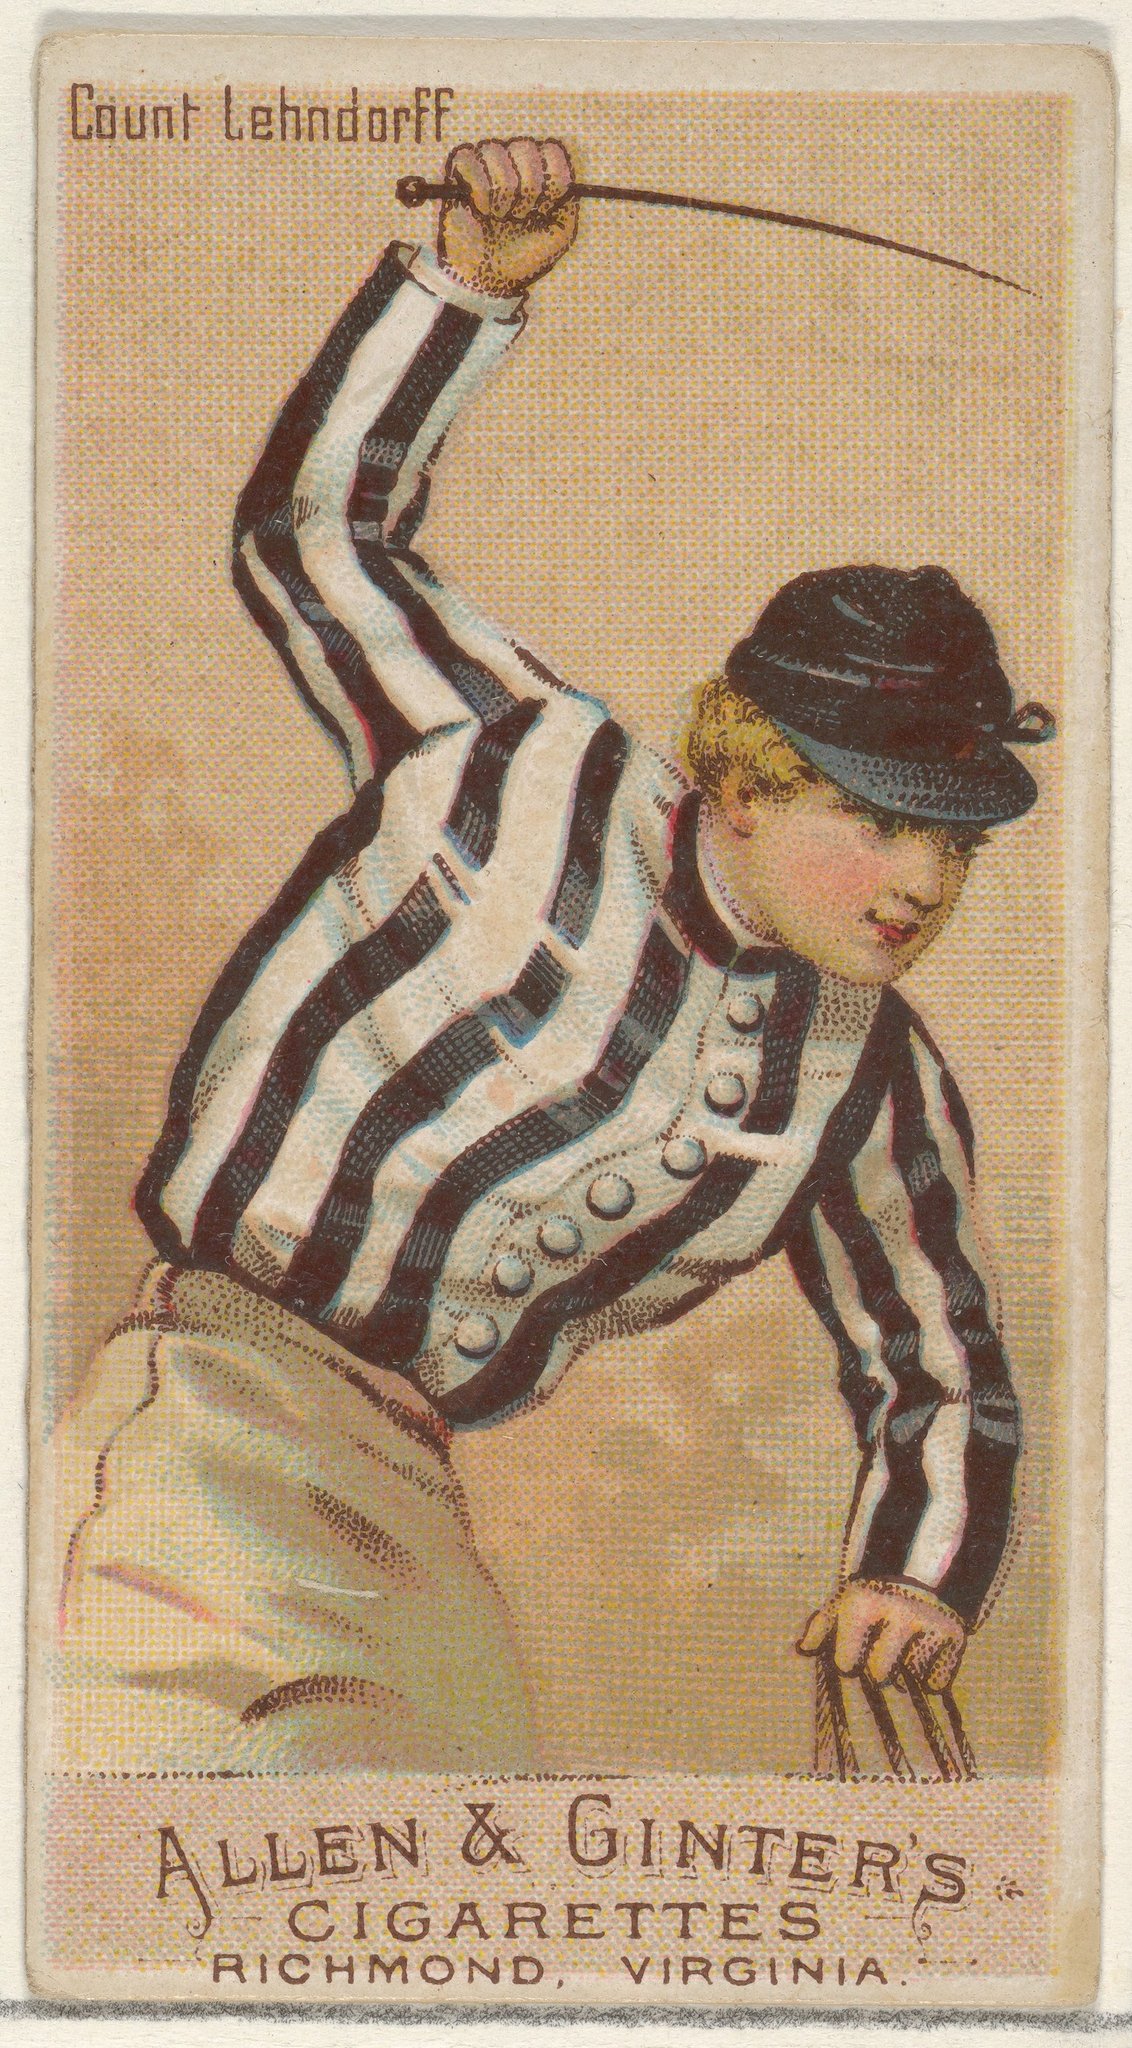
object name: print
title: Count Lehndorff, from the Racing Colors of the World series (N22a) for Allen & Ginter Cigarettes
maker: allen & ginter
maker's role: publisher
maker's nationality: american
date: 1888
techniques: color lithograph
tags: women,jockeys